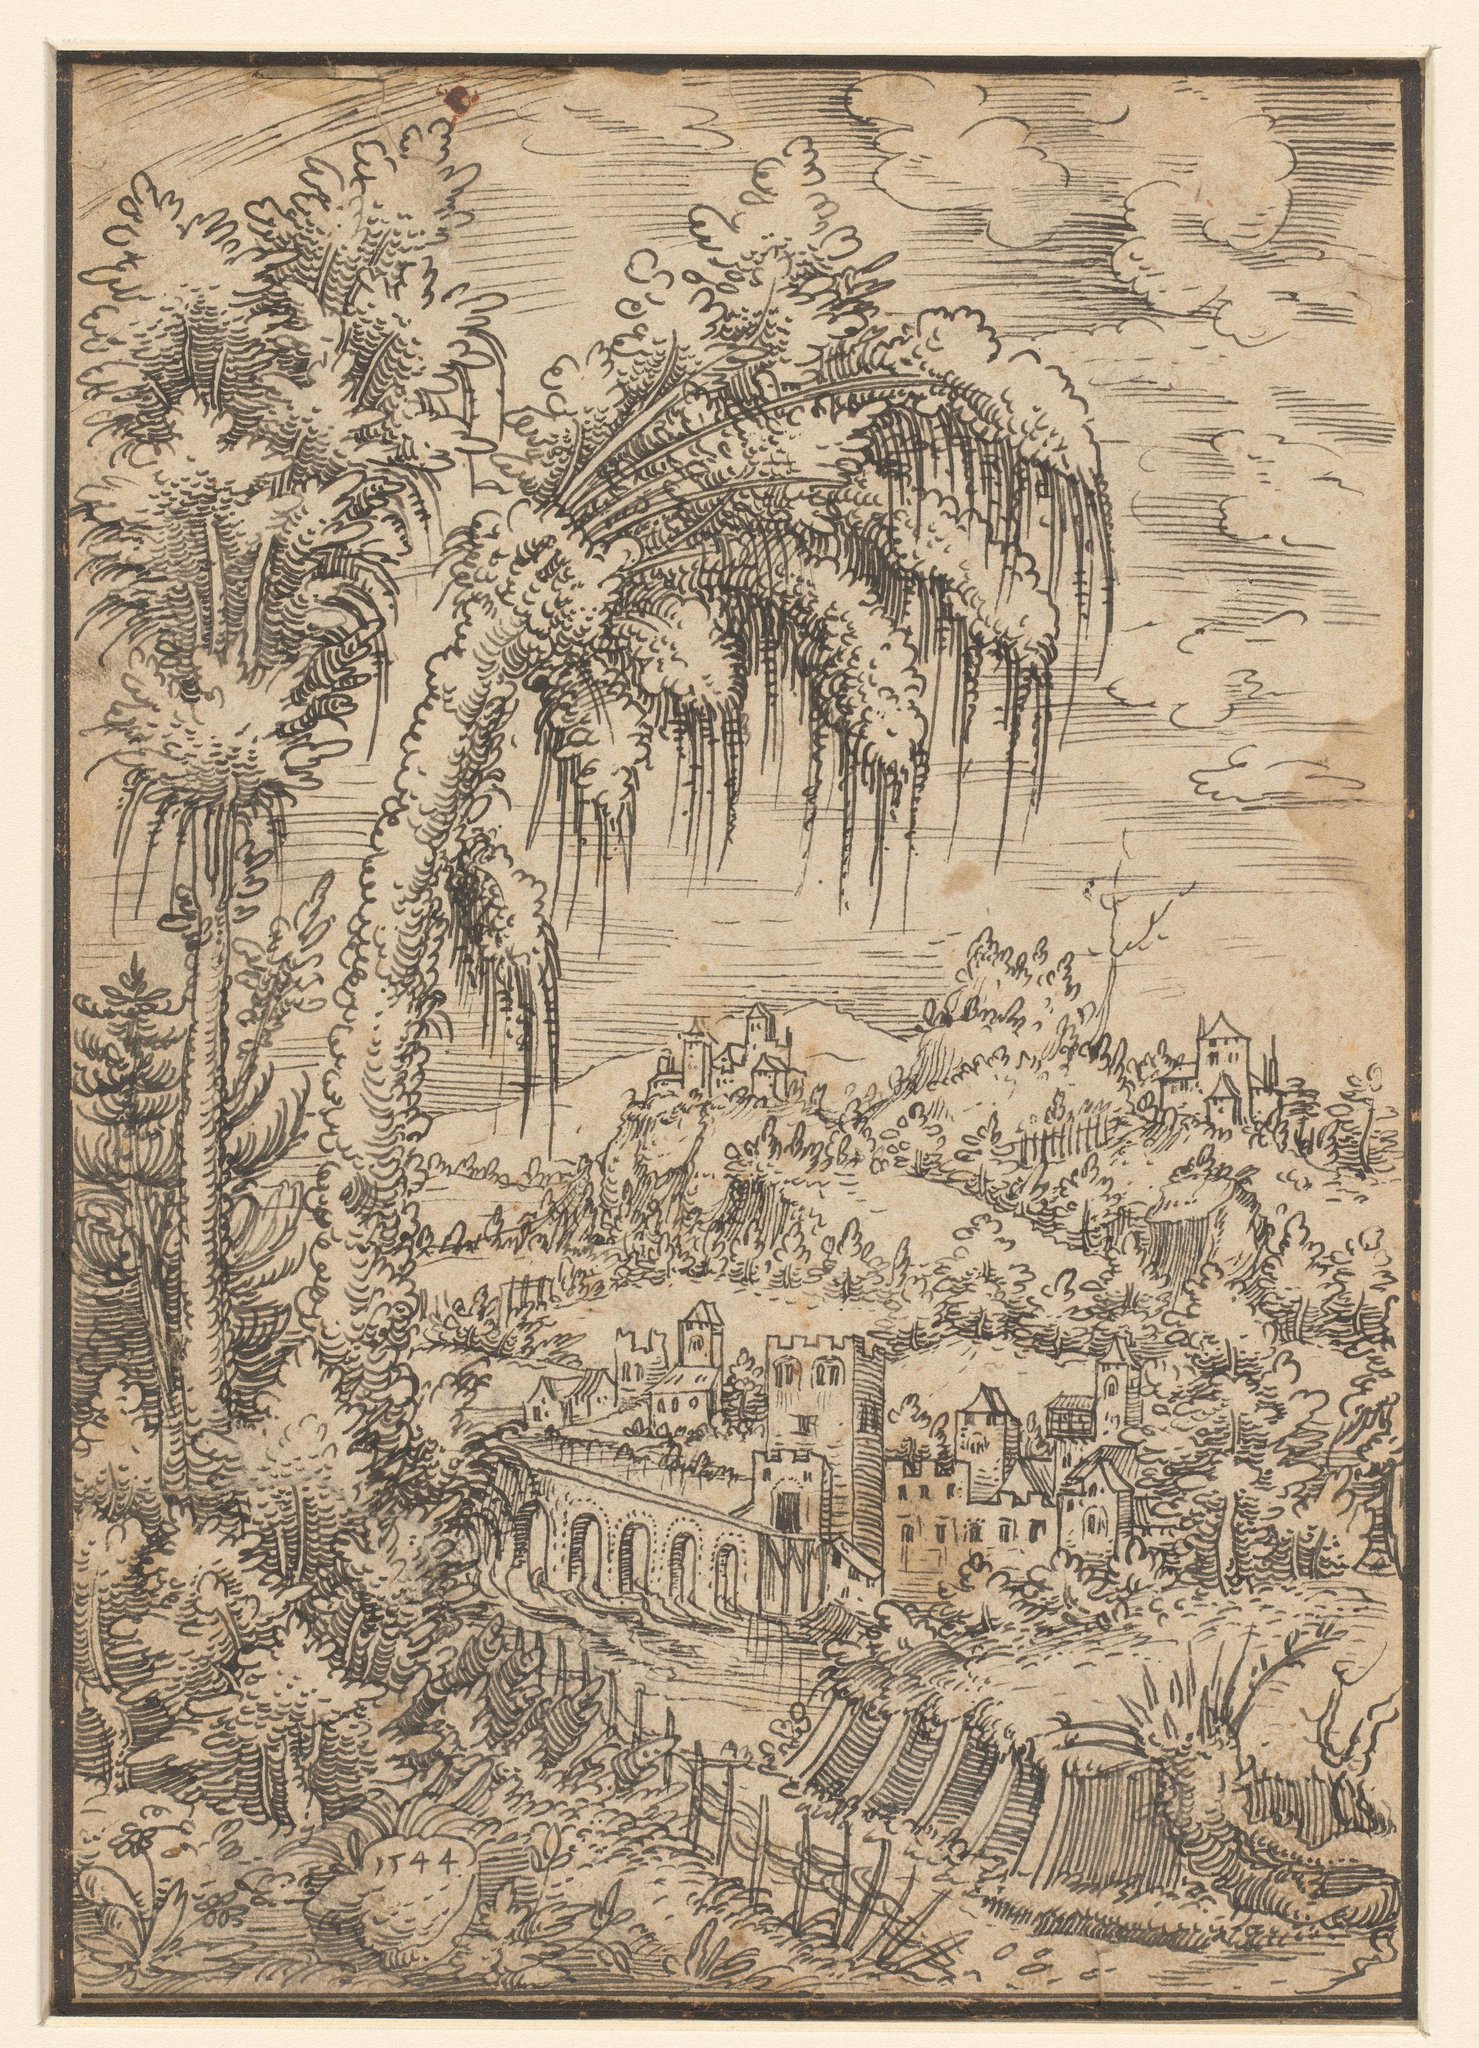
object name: drawing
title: Berglandschap en rivier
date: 1544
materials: ink, paper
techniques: pen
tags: trees, landscape with bridge, viaduct or aqueduct, mountains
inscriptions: date: ‘1544’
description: Berglandschap met overhangende bomen, rivier met brug en gebouwen.